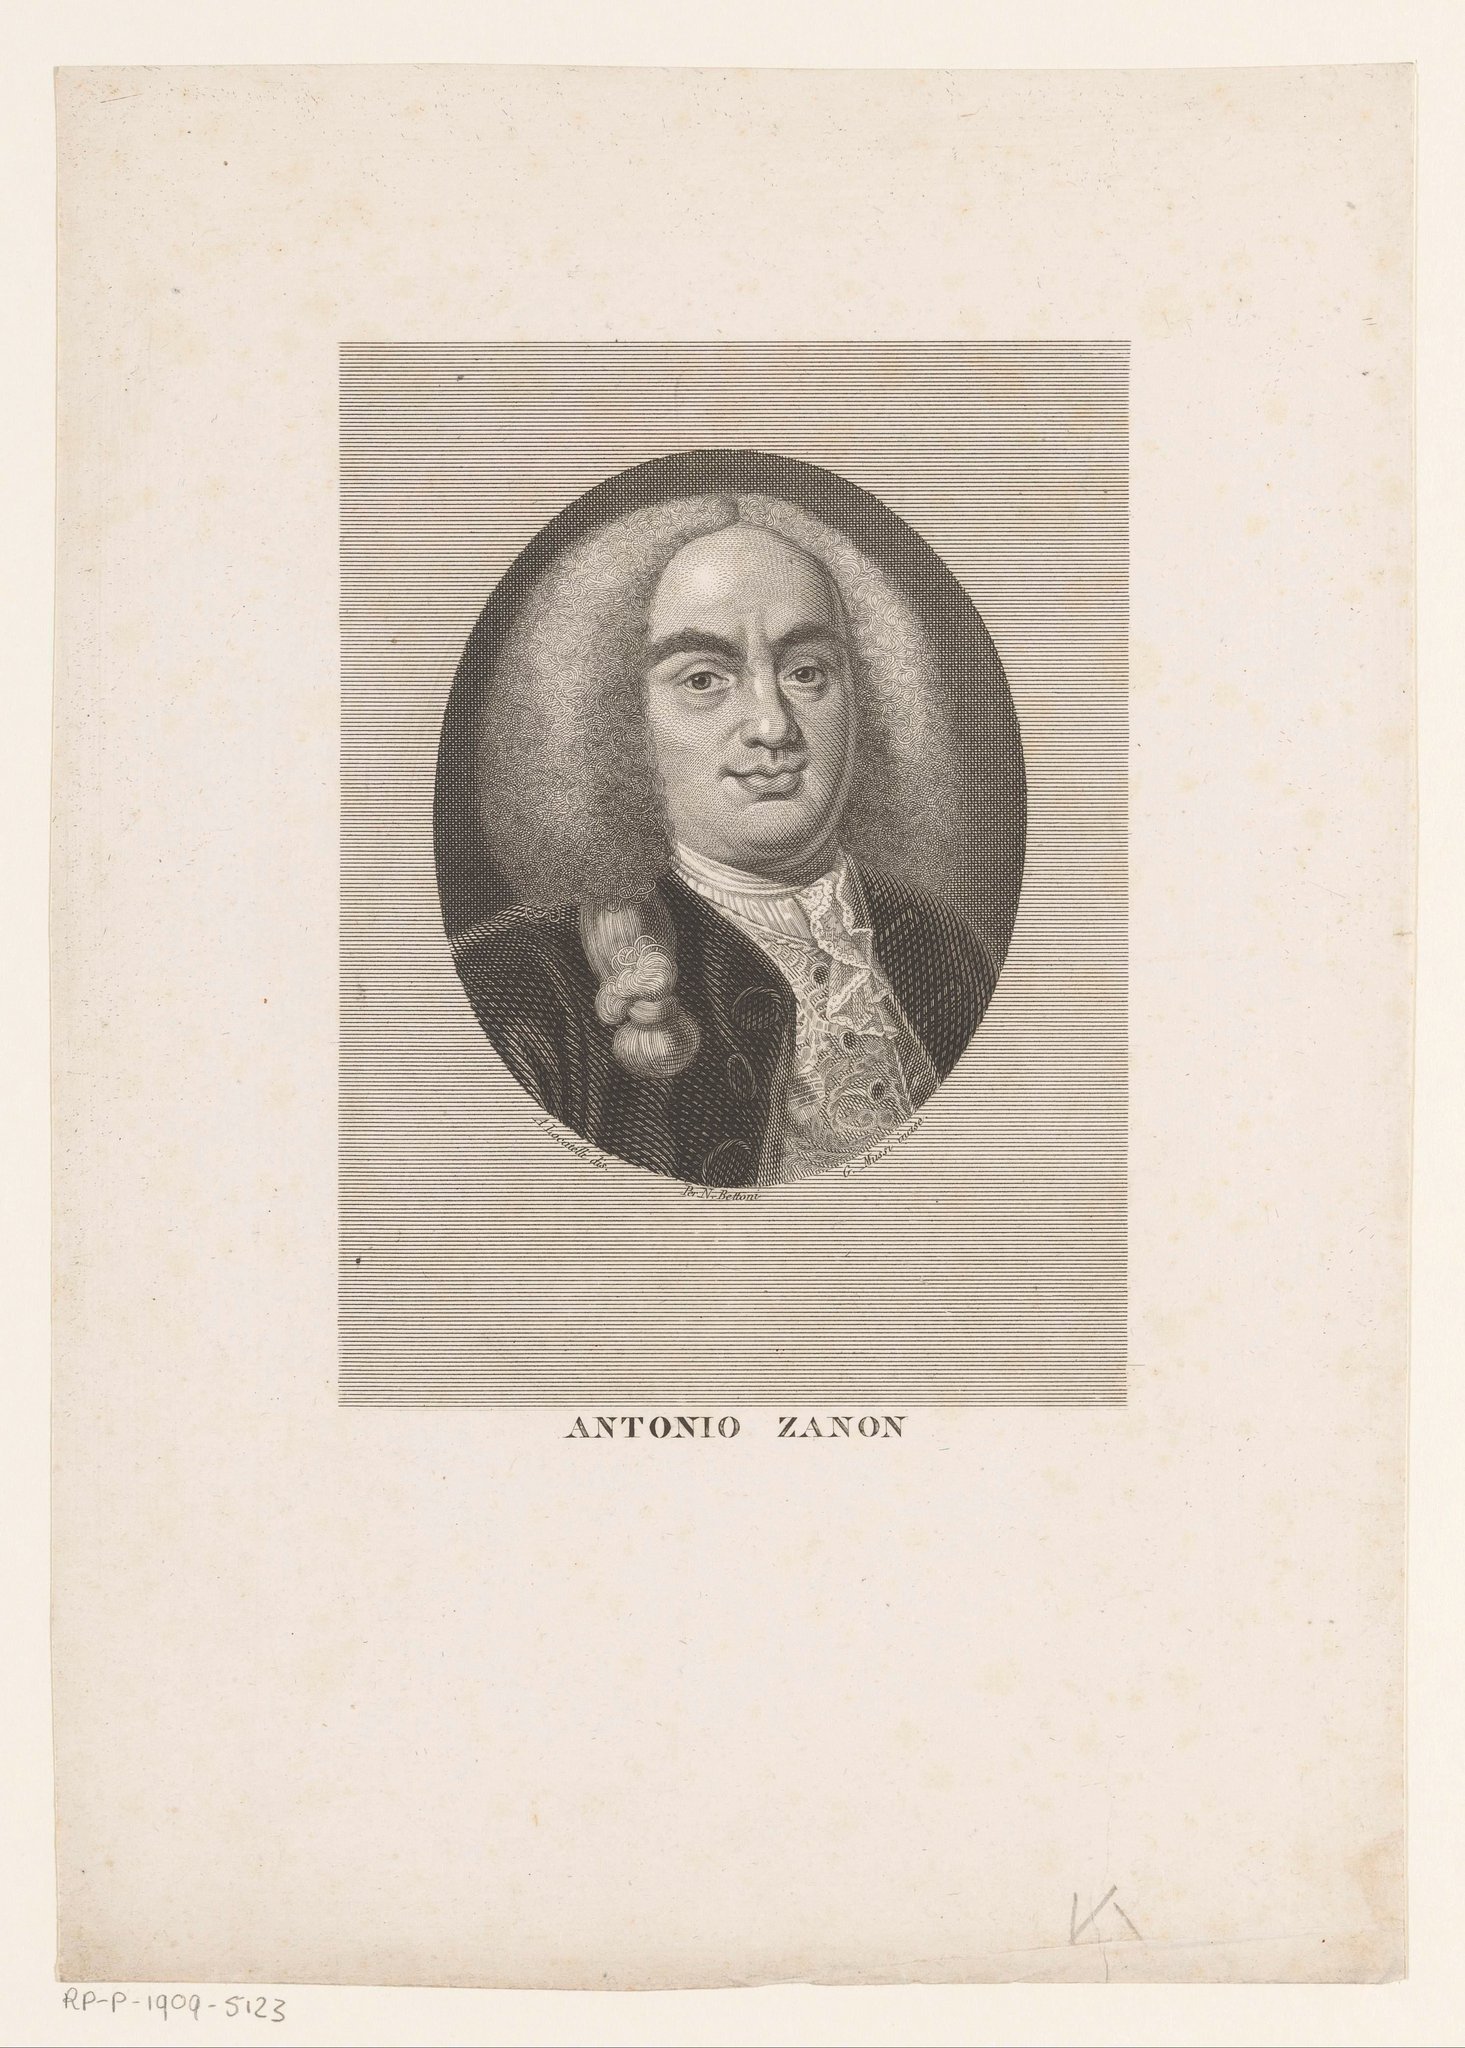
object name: print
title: Portret van econoom Antonio Zanon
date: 1875-1909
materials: paper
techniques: engraving, etching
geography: italy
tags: venice, historical persons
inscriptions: collector's mark: Lugt 2228